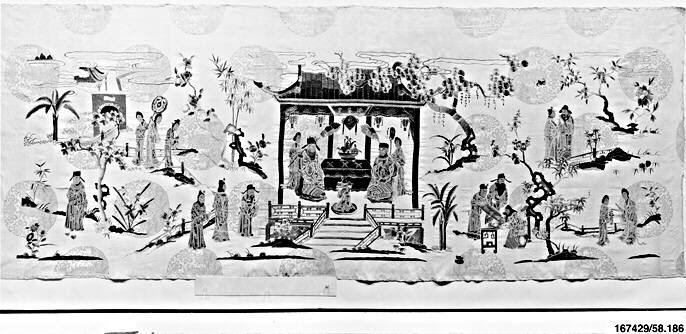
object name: hanging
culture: chinese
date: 1801-1900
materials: silk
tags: human figures,trees